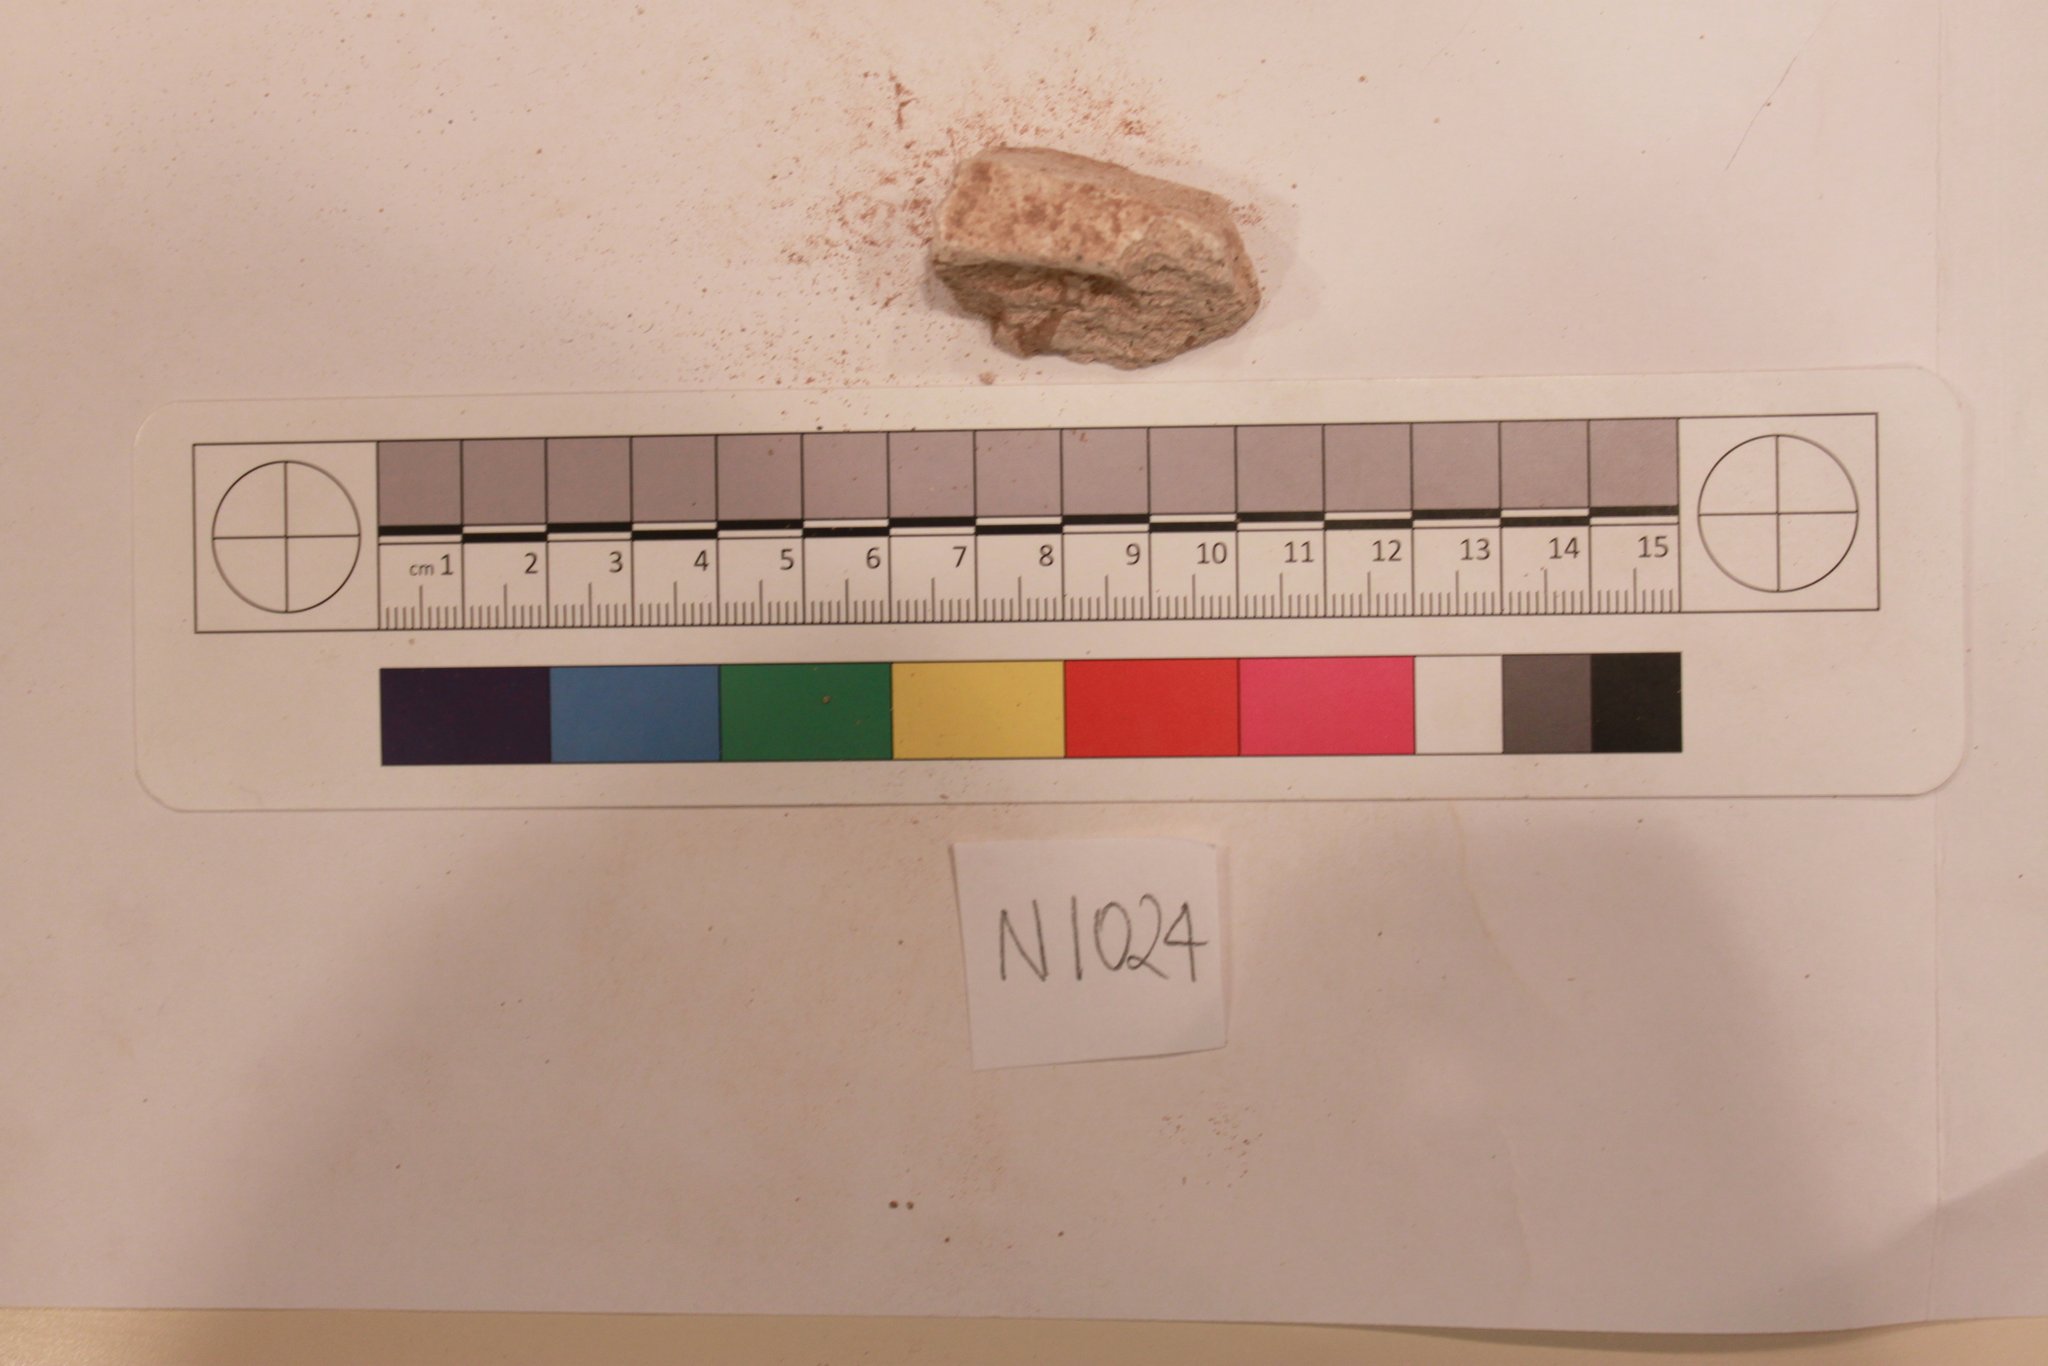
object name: fragment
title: Stucco Fragment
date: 701-1200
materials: plaster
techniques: carving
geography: iran